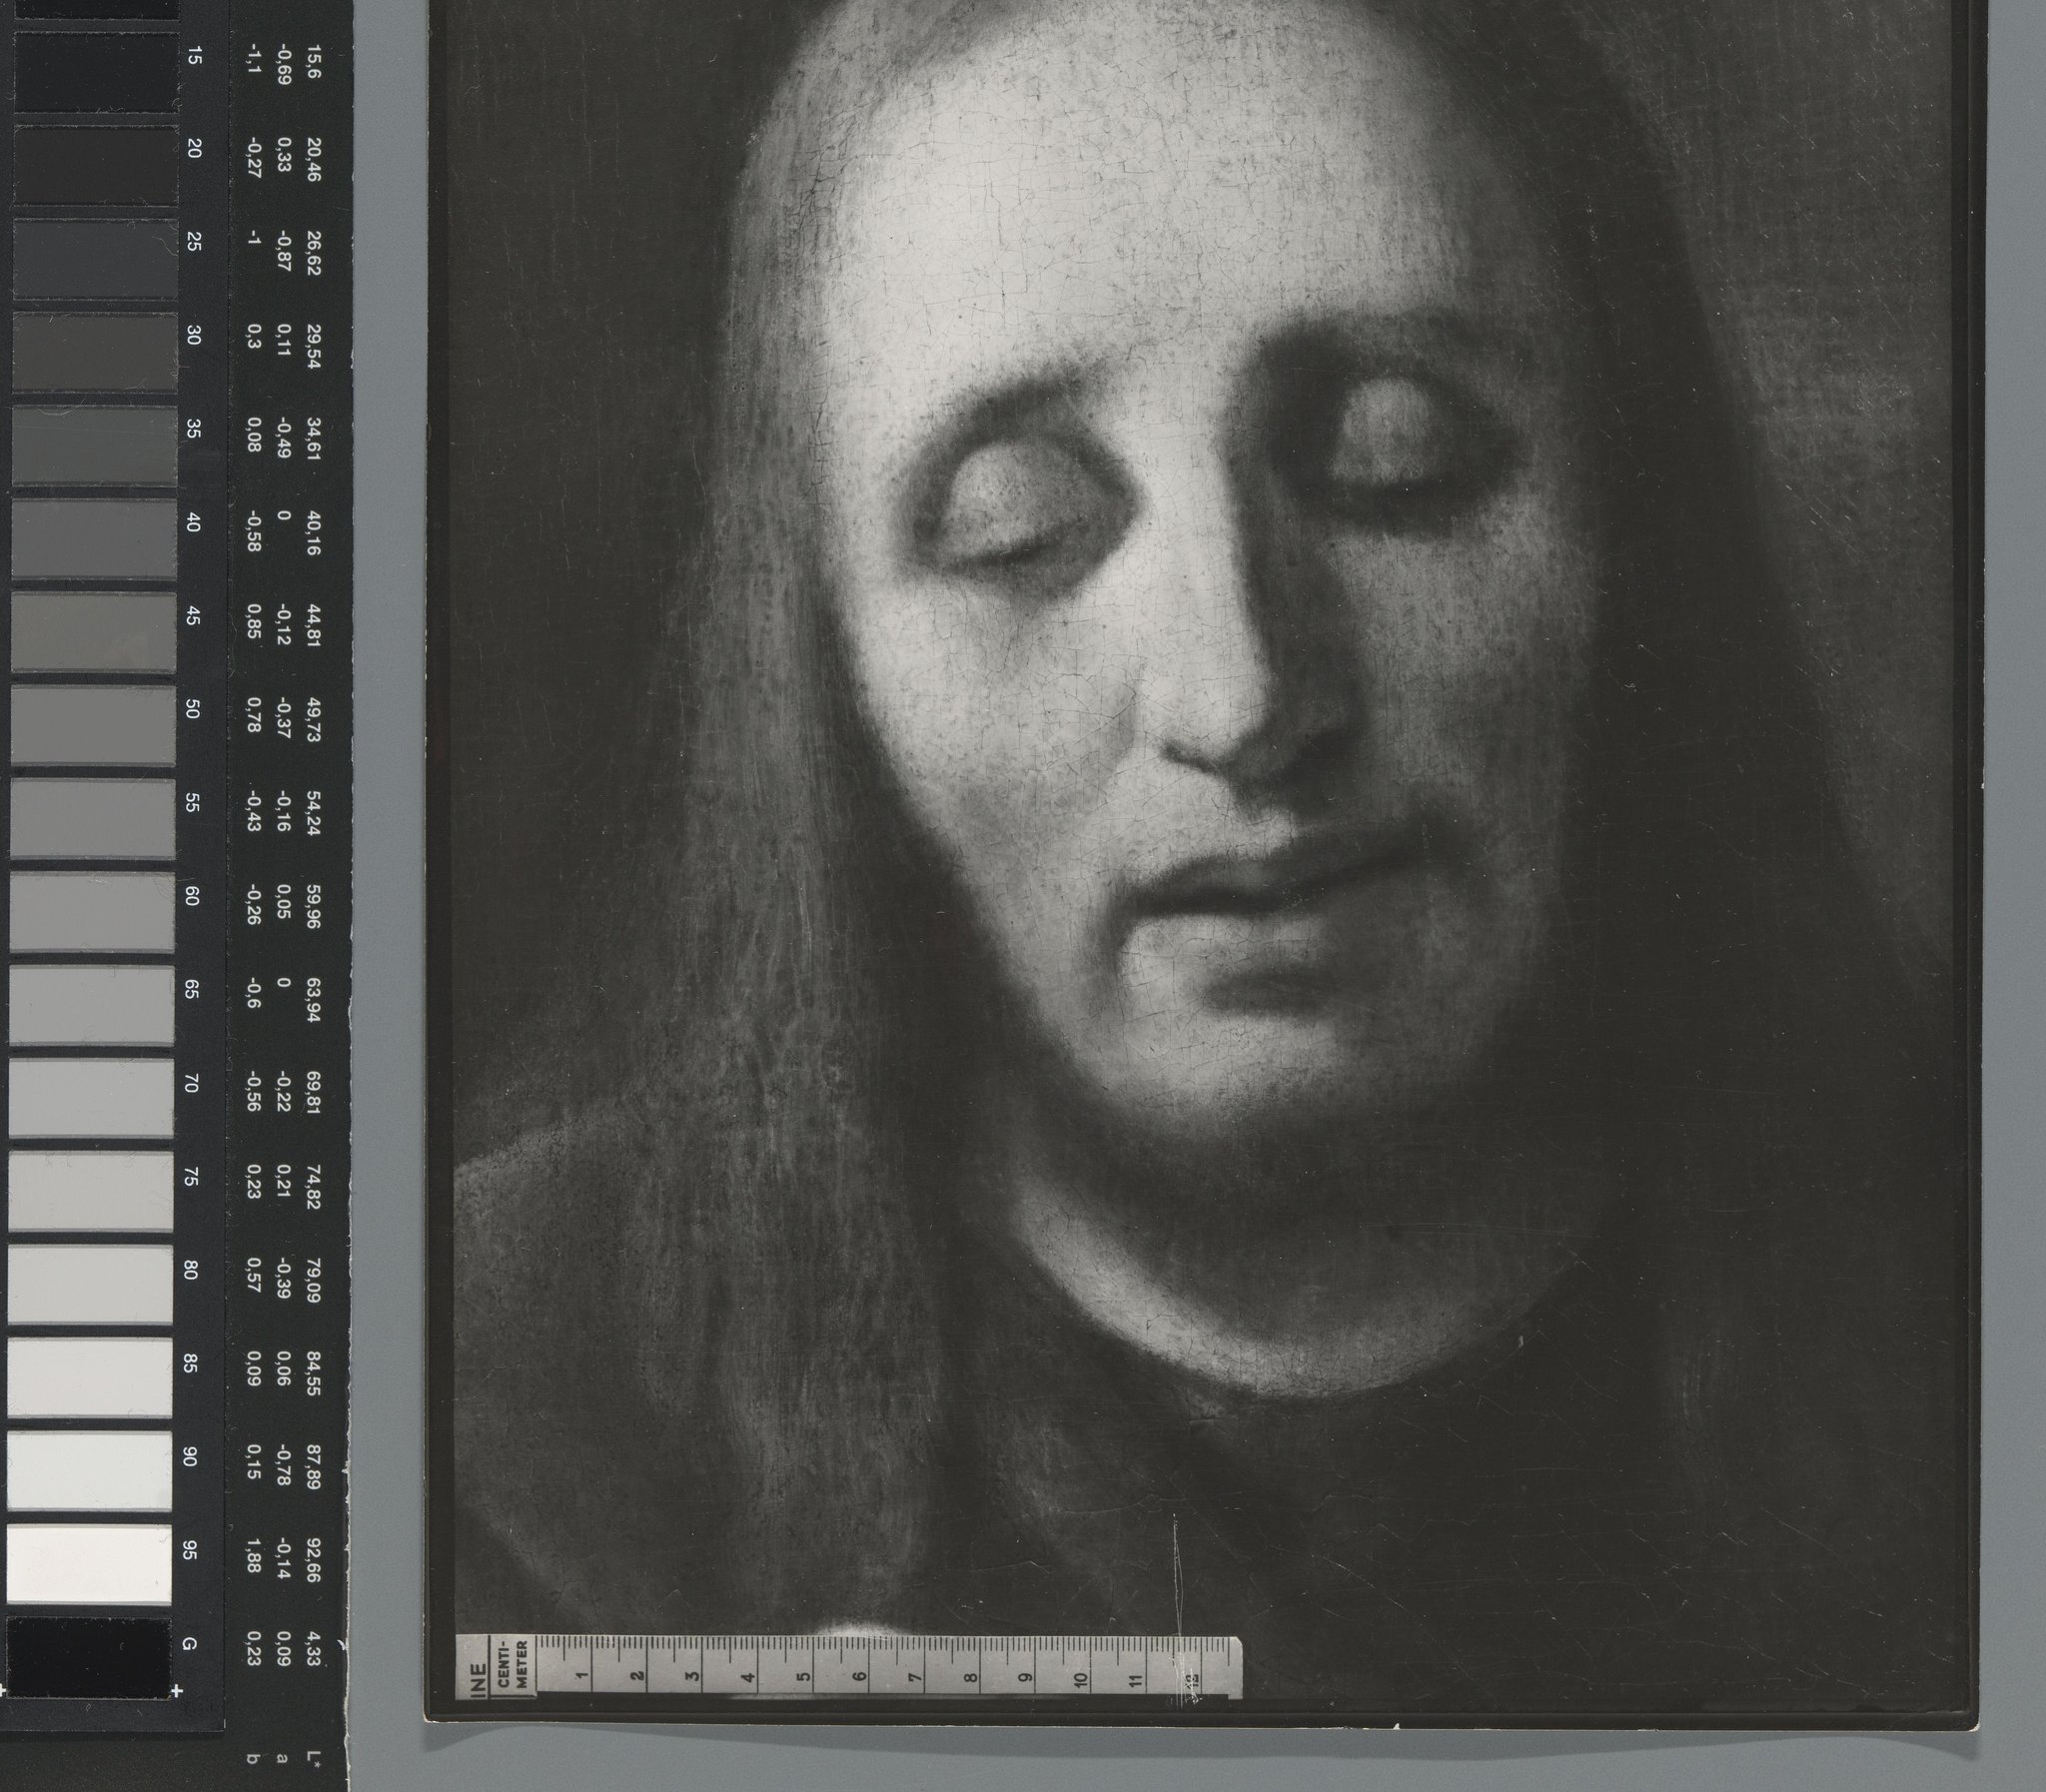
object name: photograph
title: Fotografische reproductie van een (detail) schilderij van Han van Meegeren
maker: nico zomer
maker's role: fotograaf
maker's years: 1910-1988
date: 1908-1948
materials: photographic support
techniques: gelatin silver print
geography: amsterdam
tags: picture, painting